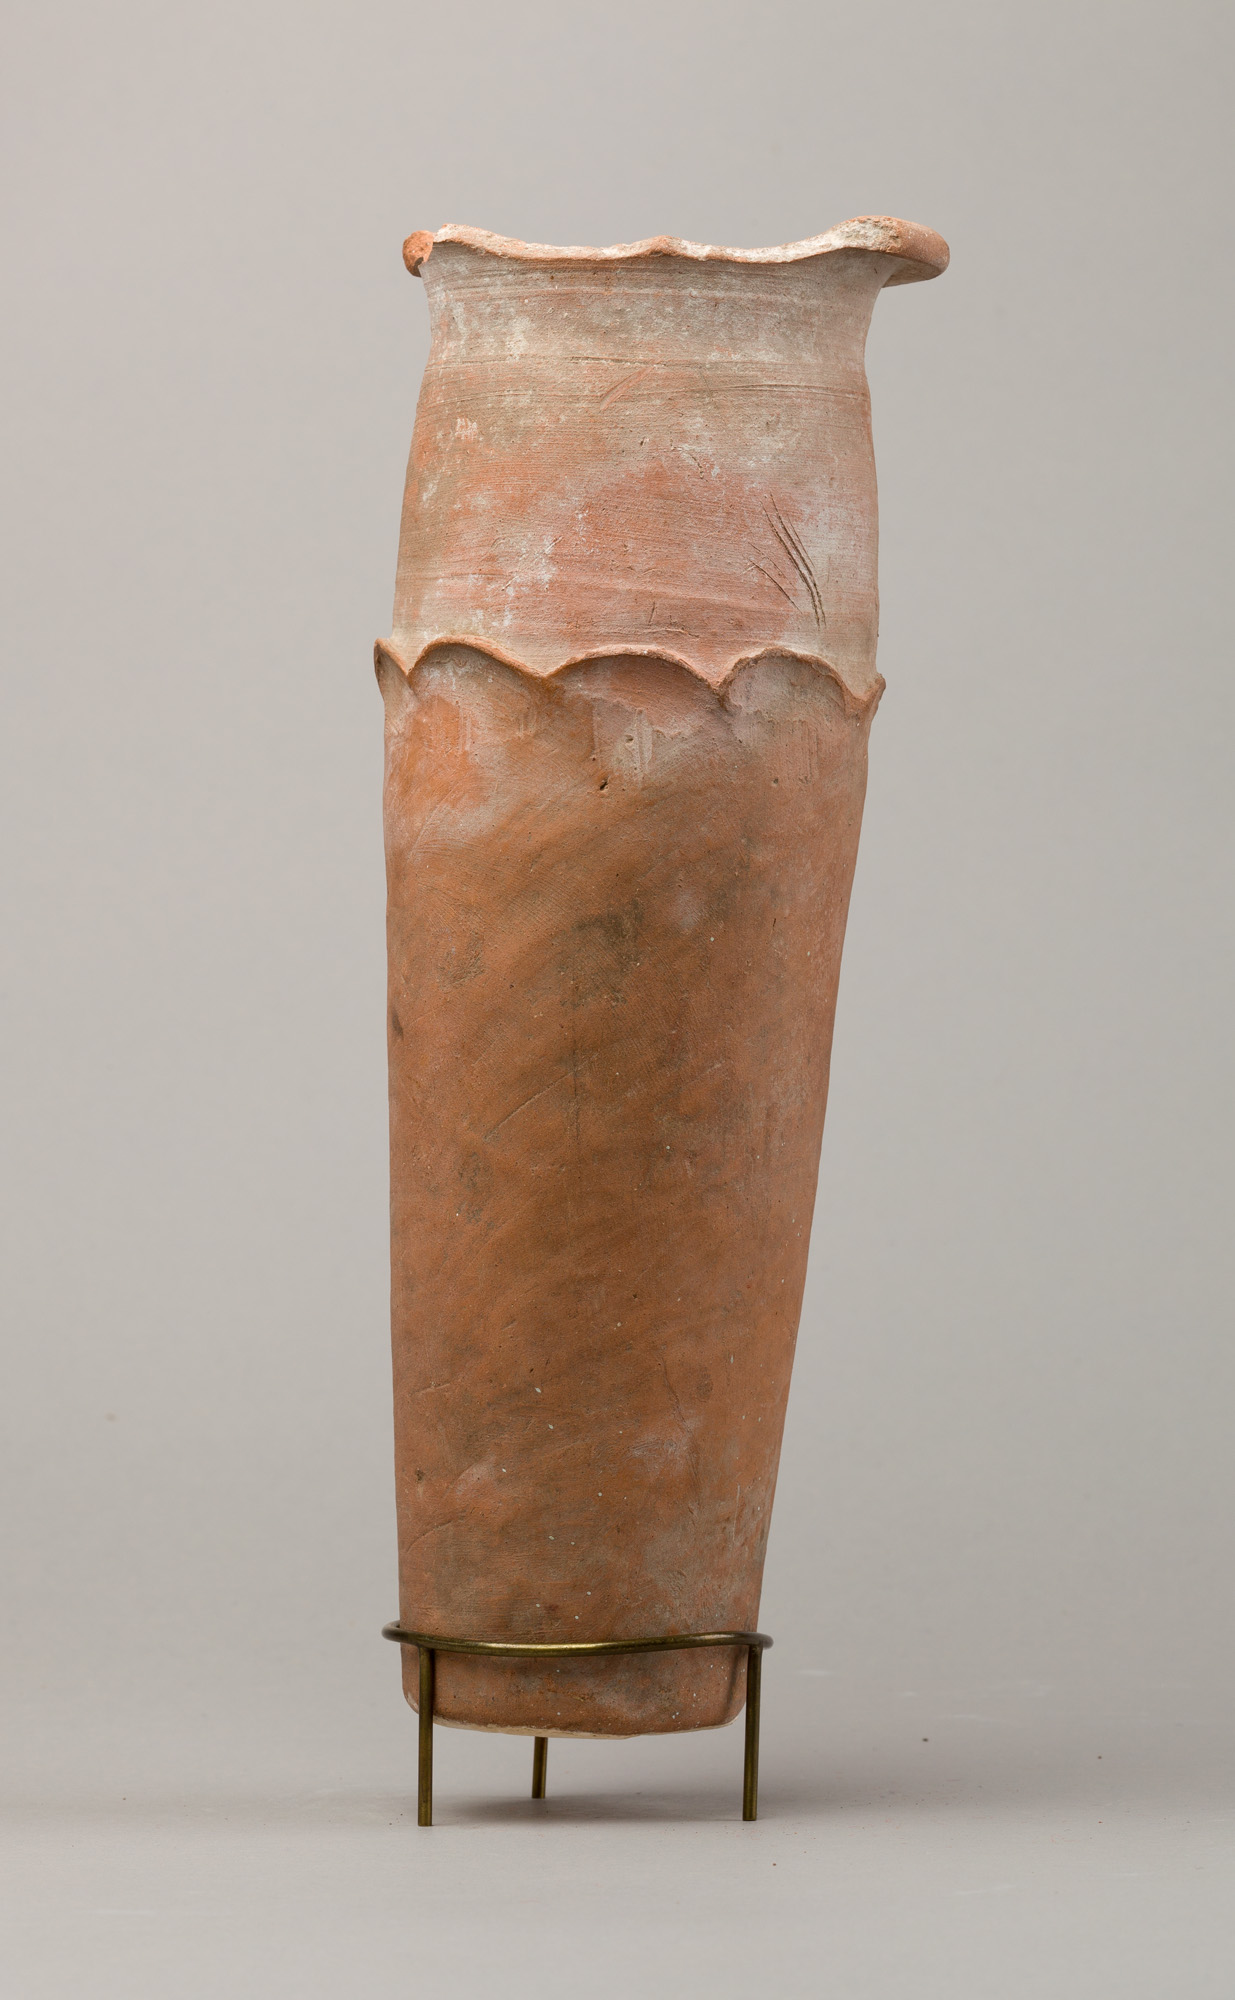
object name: jar, cylindrical, wavy handled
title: Wavy-handled jar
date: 3850-2960 BCE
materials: pottery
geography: egypt